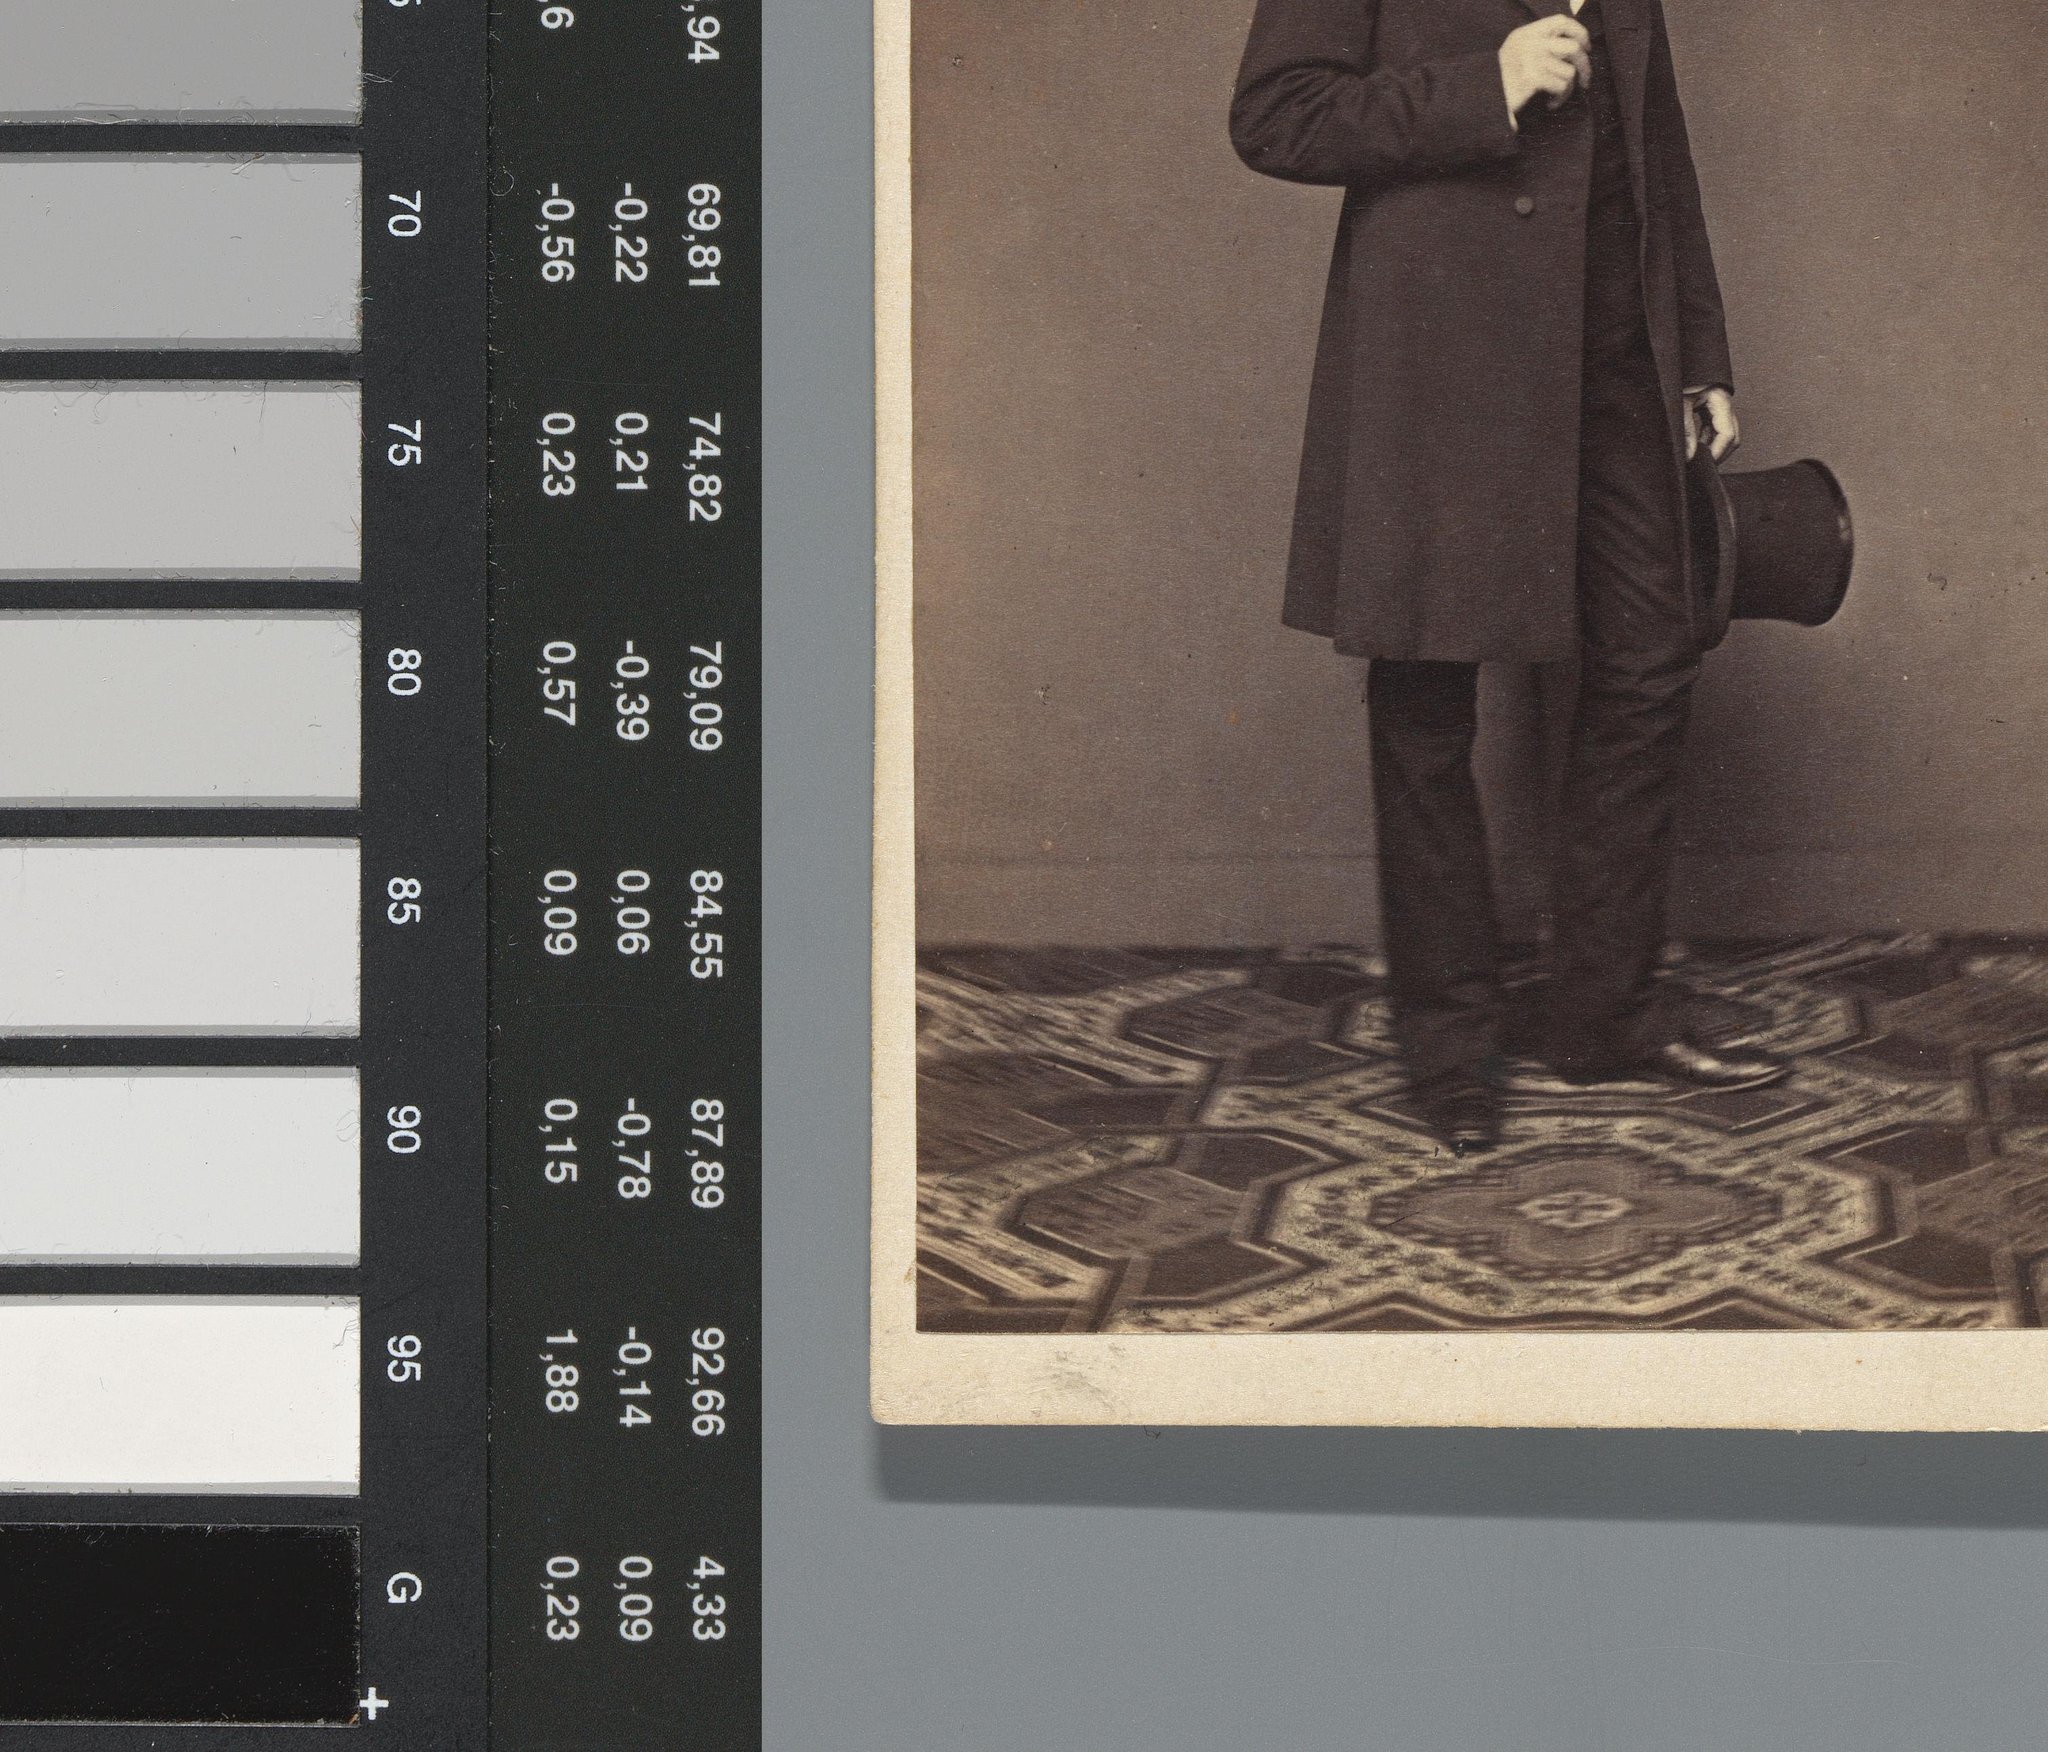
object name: carte de visite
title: Portret van Henri E.C. van Kerckhoff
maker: gerrit hoogwinkel jr.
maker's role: fotograaf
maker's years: 1837-1890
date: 1855-1910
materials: cardboard, photographic support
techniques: albumen print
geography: rotterdam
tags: henri e.c. kerckhoff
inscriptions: name: ‘mr Henri E.C. / van Kerckhoff’